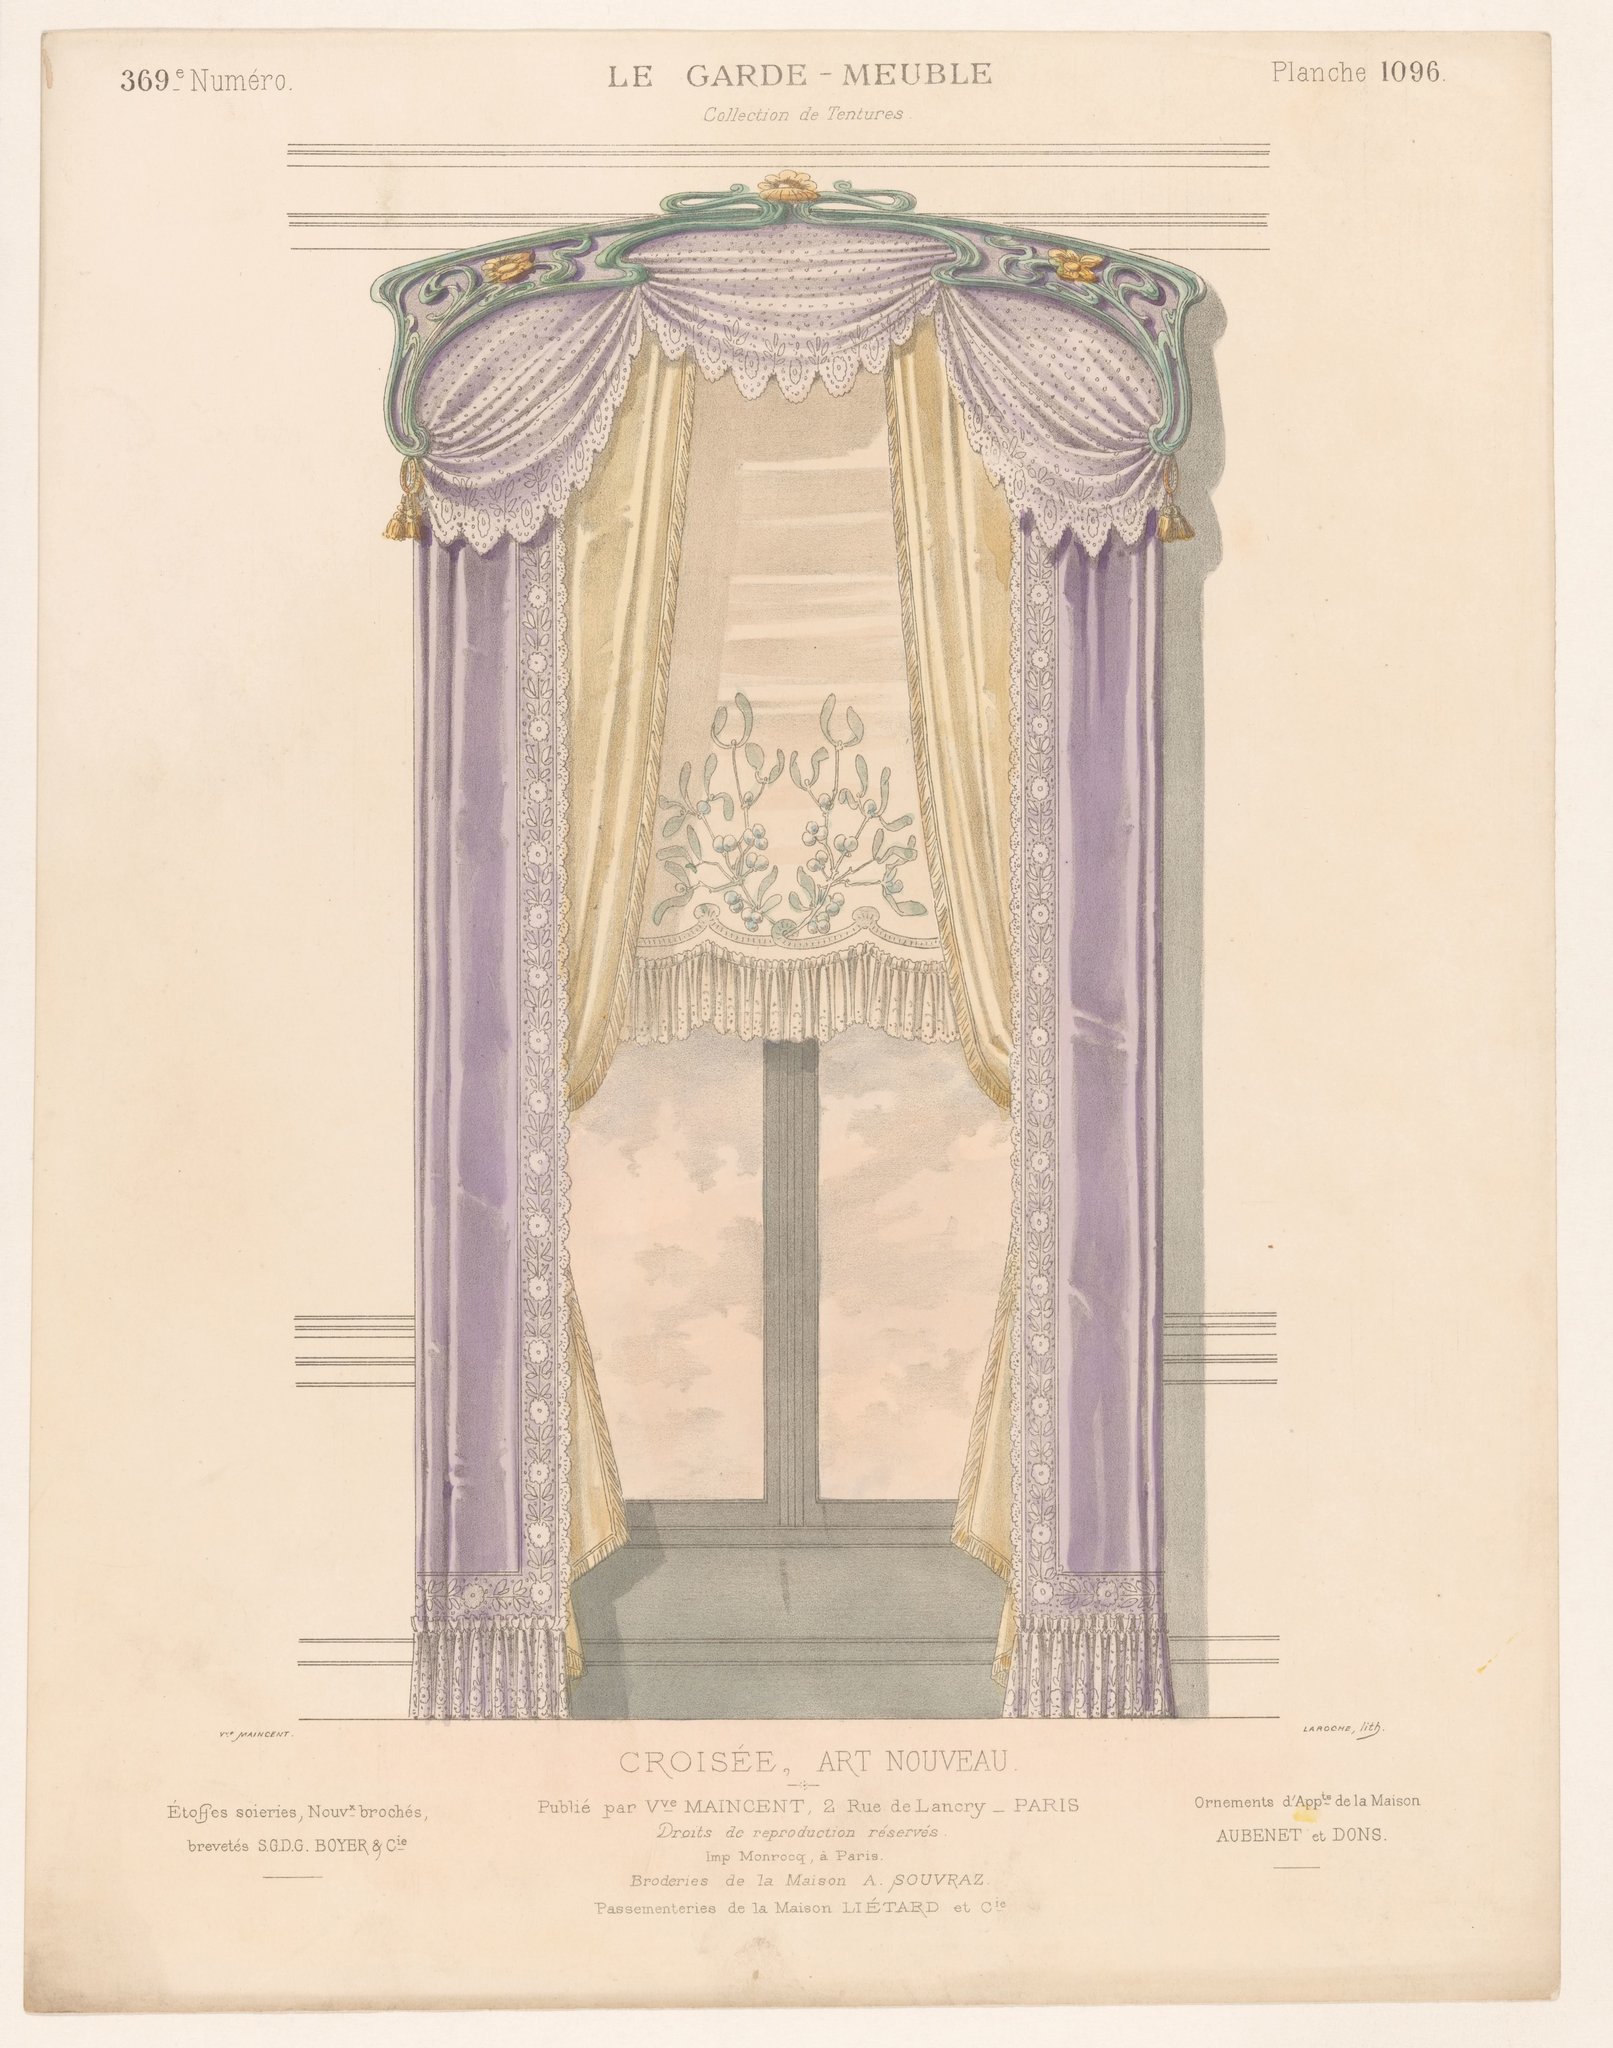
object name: print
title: Venster met gordijnen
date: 1895-1910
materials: paper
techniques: hand coloring, lithograph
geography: paris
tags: window, hangings and drapery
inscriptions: : ‘Droits de reproduction réservés.’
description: Kruisvenster met gedrapeerde gordijnen in de art-nouveaustijl. Prent uit 369e Livraison.